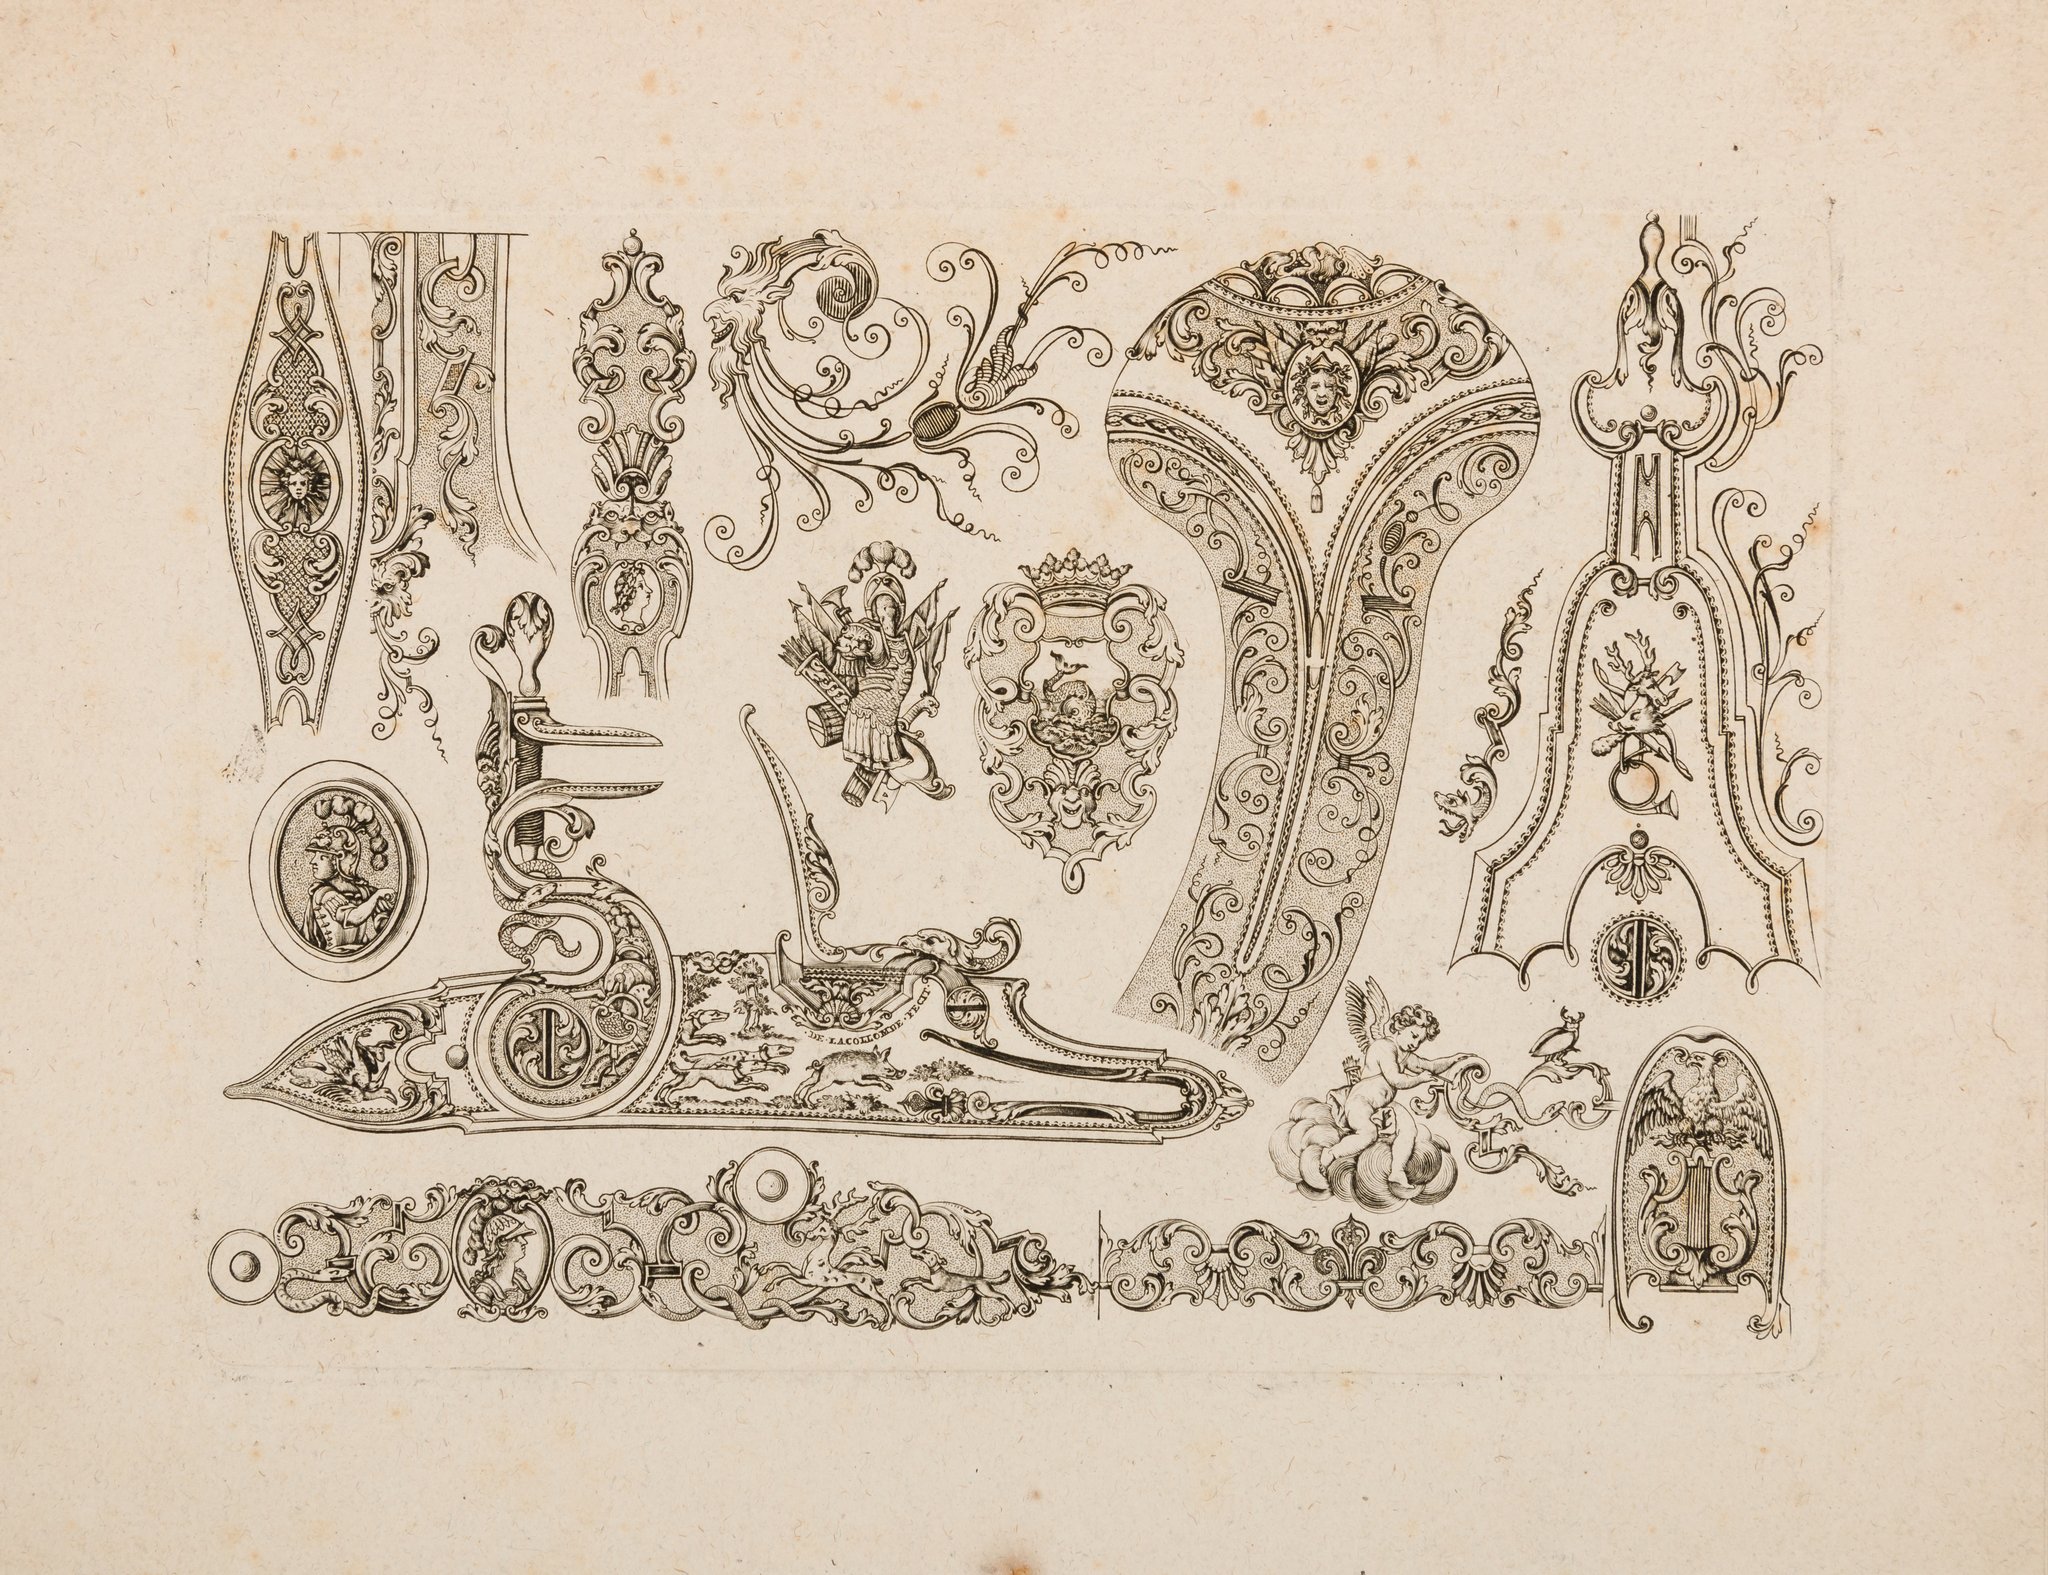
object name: engraving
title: Plate Four from Nouveavx Desseins D'Arquebvseries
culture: french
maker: de lacollombe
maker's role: engraver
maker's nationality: french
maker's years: 1702-1736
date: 1730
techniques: engraving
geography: france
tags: ornament